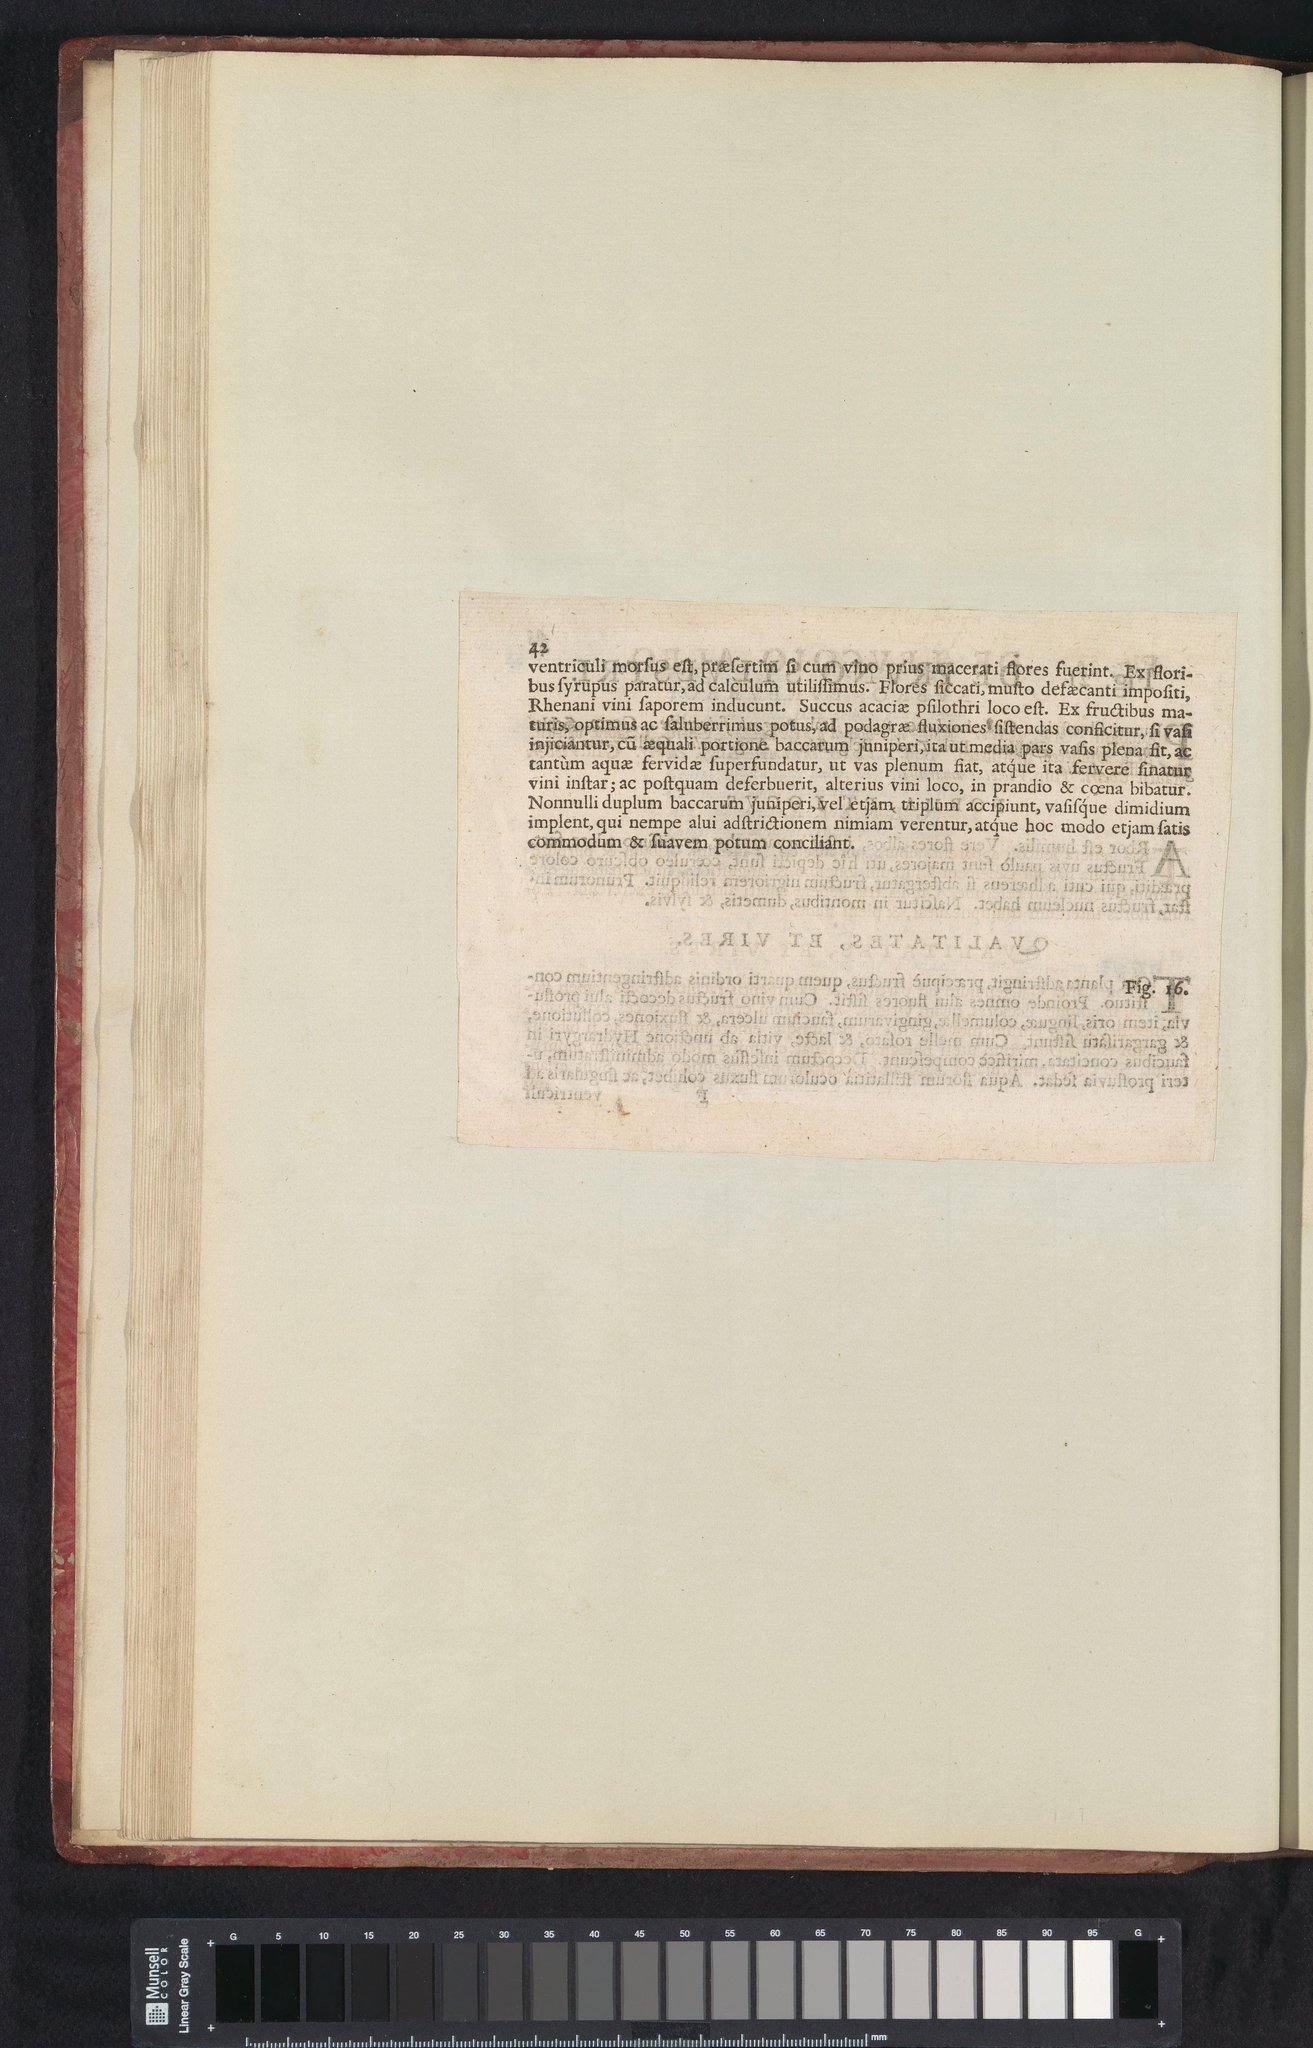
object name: text sheet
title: Fig. 21 'De Prvno Sylvestri' in De Boodts herbarium van 1640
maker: anselmus boëtius de boodt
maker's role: draughtsman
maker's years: 1550-1632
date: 1640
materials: ink, paper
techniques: letterpress printing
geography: bruges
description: Beschrijving bij Fig. 21 op p. 42 in: Anselmi Boëtii de Boot I.C. Brugensis & Rodolphi II. Imp. Roman. medici a cubiculis Florum, Herbarum, ac fructuum selectiorum icones, & vires pleraeque hactenus ignotæ. Onderdeel van het album met bladen en platen uit De Boodts herbarium van 1640. Het twaalfde van twaalf albums met aquarellen van dieren, vogels en planten bekend rond 1600, gemaakt in opdracht van keizer Rudolf II.